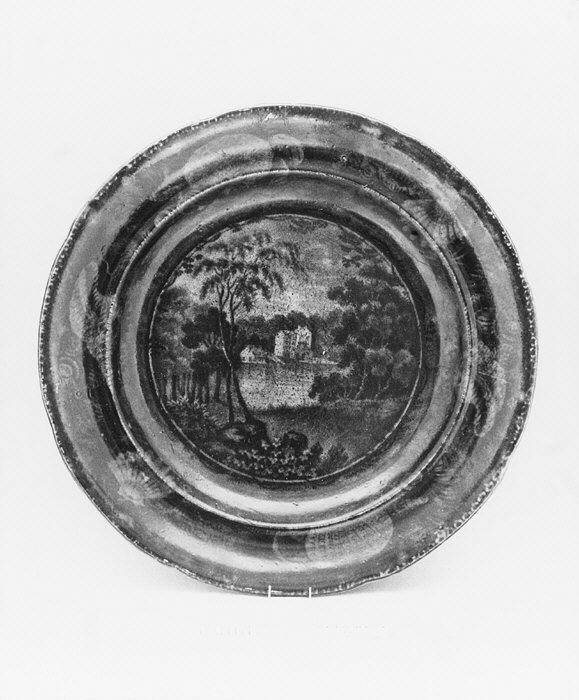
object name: plate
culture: british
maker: enoch wood & sons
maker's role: maker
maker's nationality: british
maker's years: 1818-1846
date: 1820-1846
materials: earthenware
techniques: transfer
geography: england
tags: landscapes